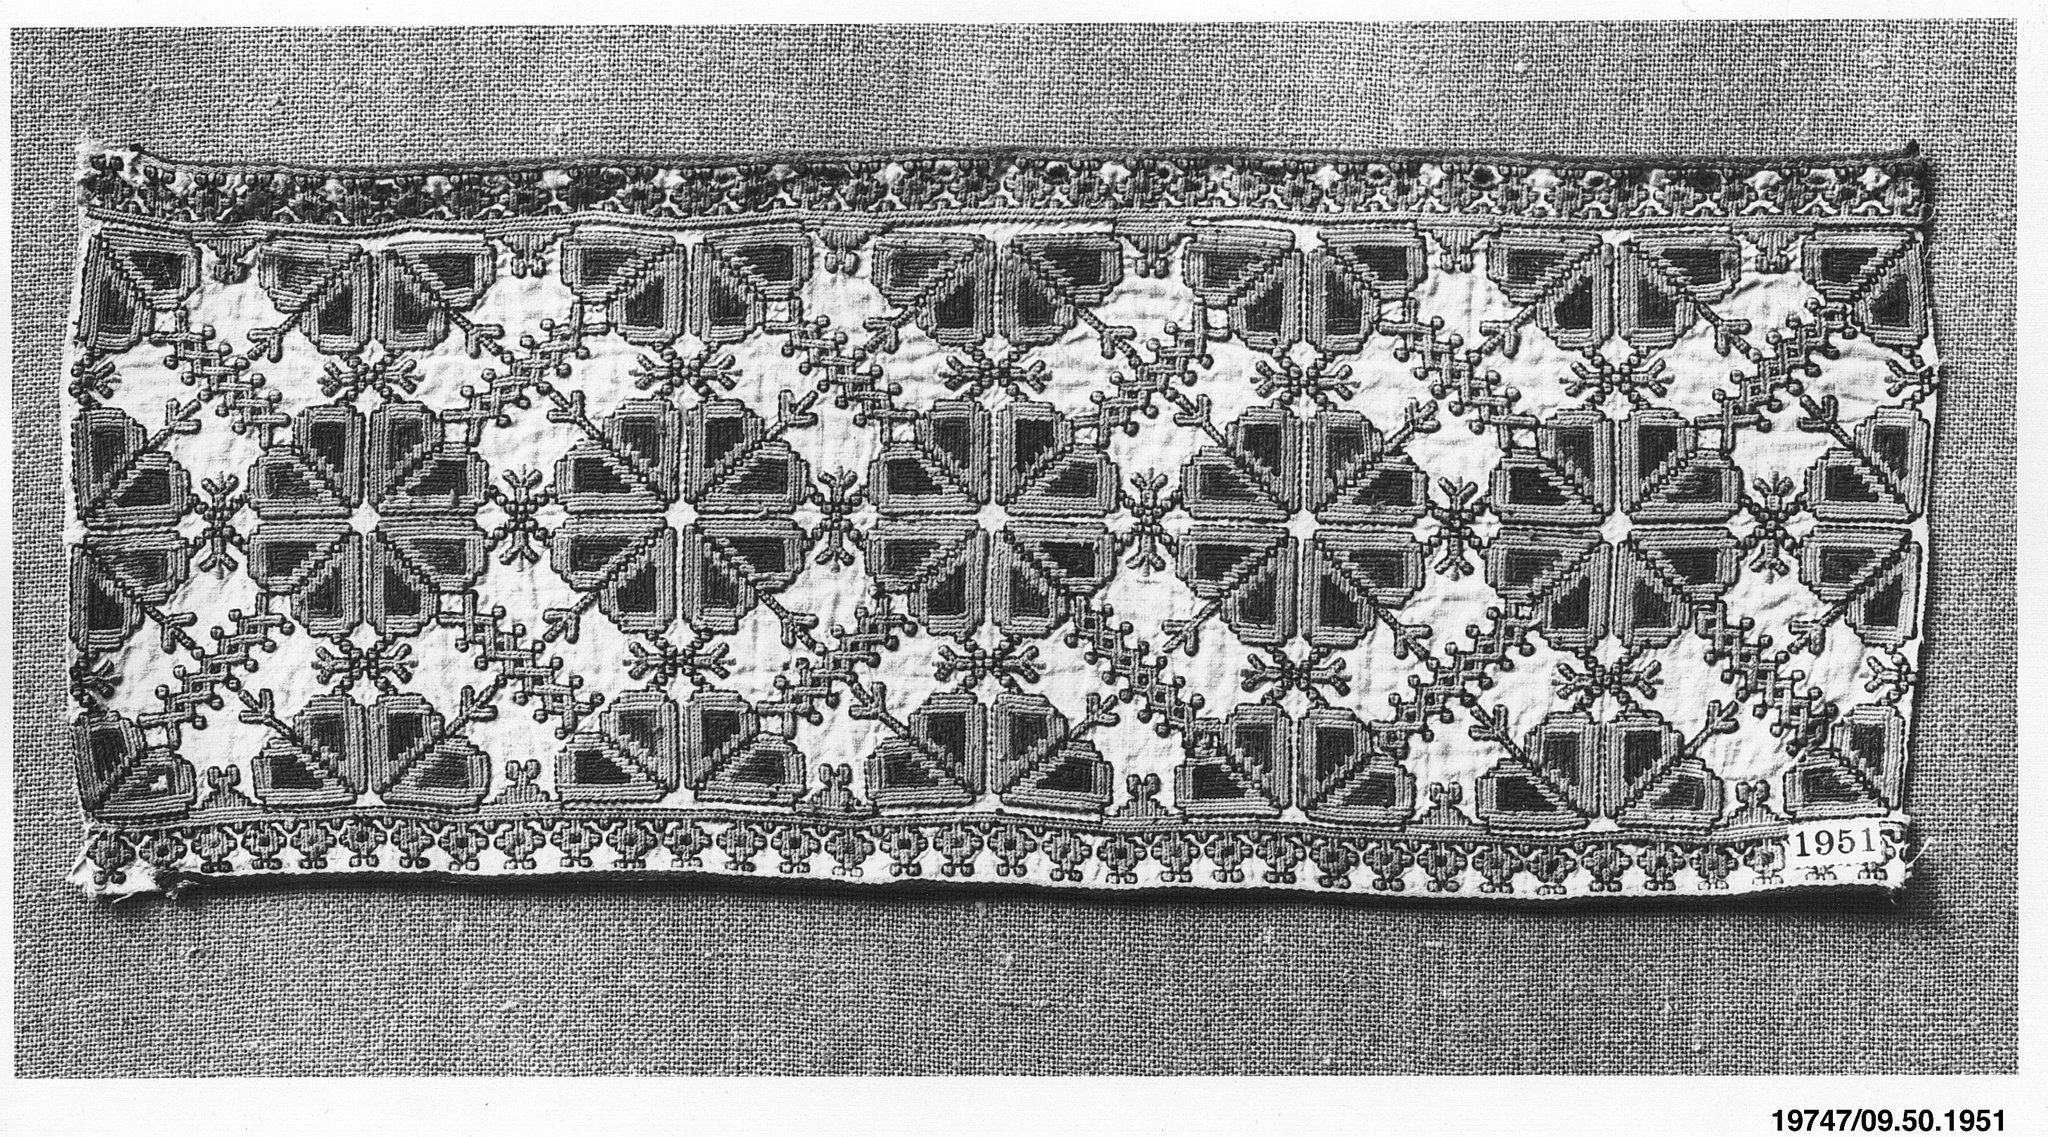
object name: piece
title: Sleeve band (?)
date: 1701-1800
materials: cotton